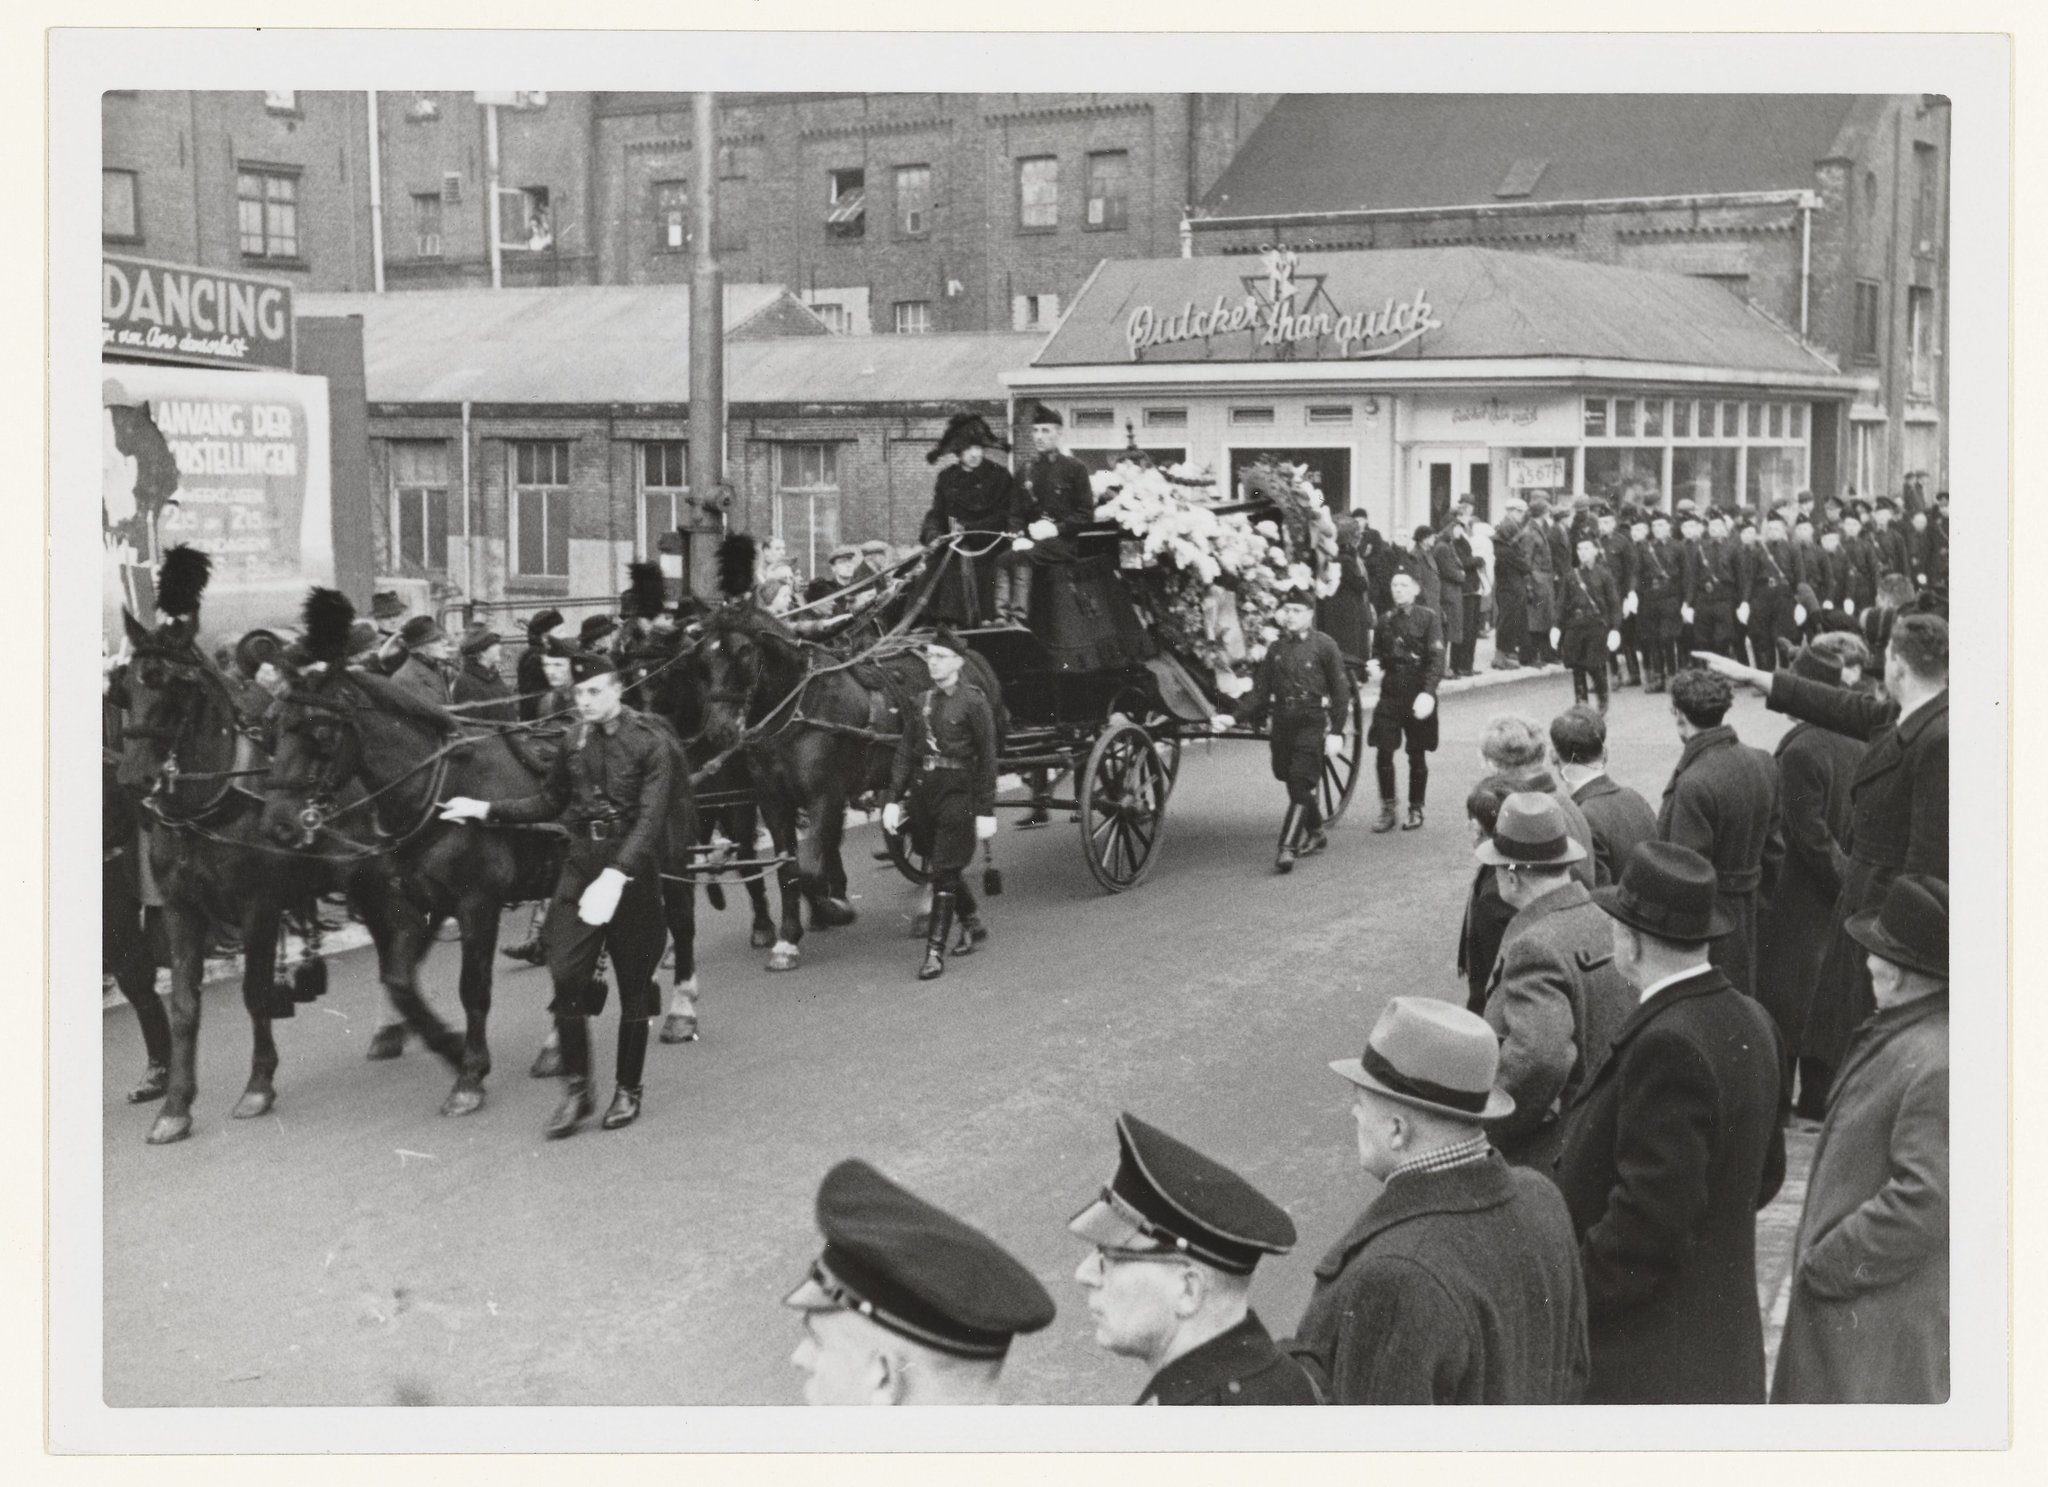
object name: photograph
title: NSB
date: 1941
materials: photographic support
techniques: photography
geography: amsterdam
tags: amsterdam, cortege, funeral procession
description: De begrafenis van Hendrik Koot. Koot, 42 jaar, was wachtmeester van de WA en raakte zwaar gewond op 11 februari tijdens gevechten met Joodse bewoners, uitgelokt door de WA. Hij stierf op 12 februari en werd de 17de op Zorgvlied begraven. De koets met paarden en begeleid door WAers trekt over de Vijzelgracht, langs de kant enige belangstellenden. Een van hen brengt de NSB groet. De dood van Koot en daarna volgende rellen leidden tot razzia's op de joden, deze werden de aanleiding tot de februaristaking op 25 en 26 februari 1941.